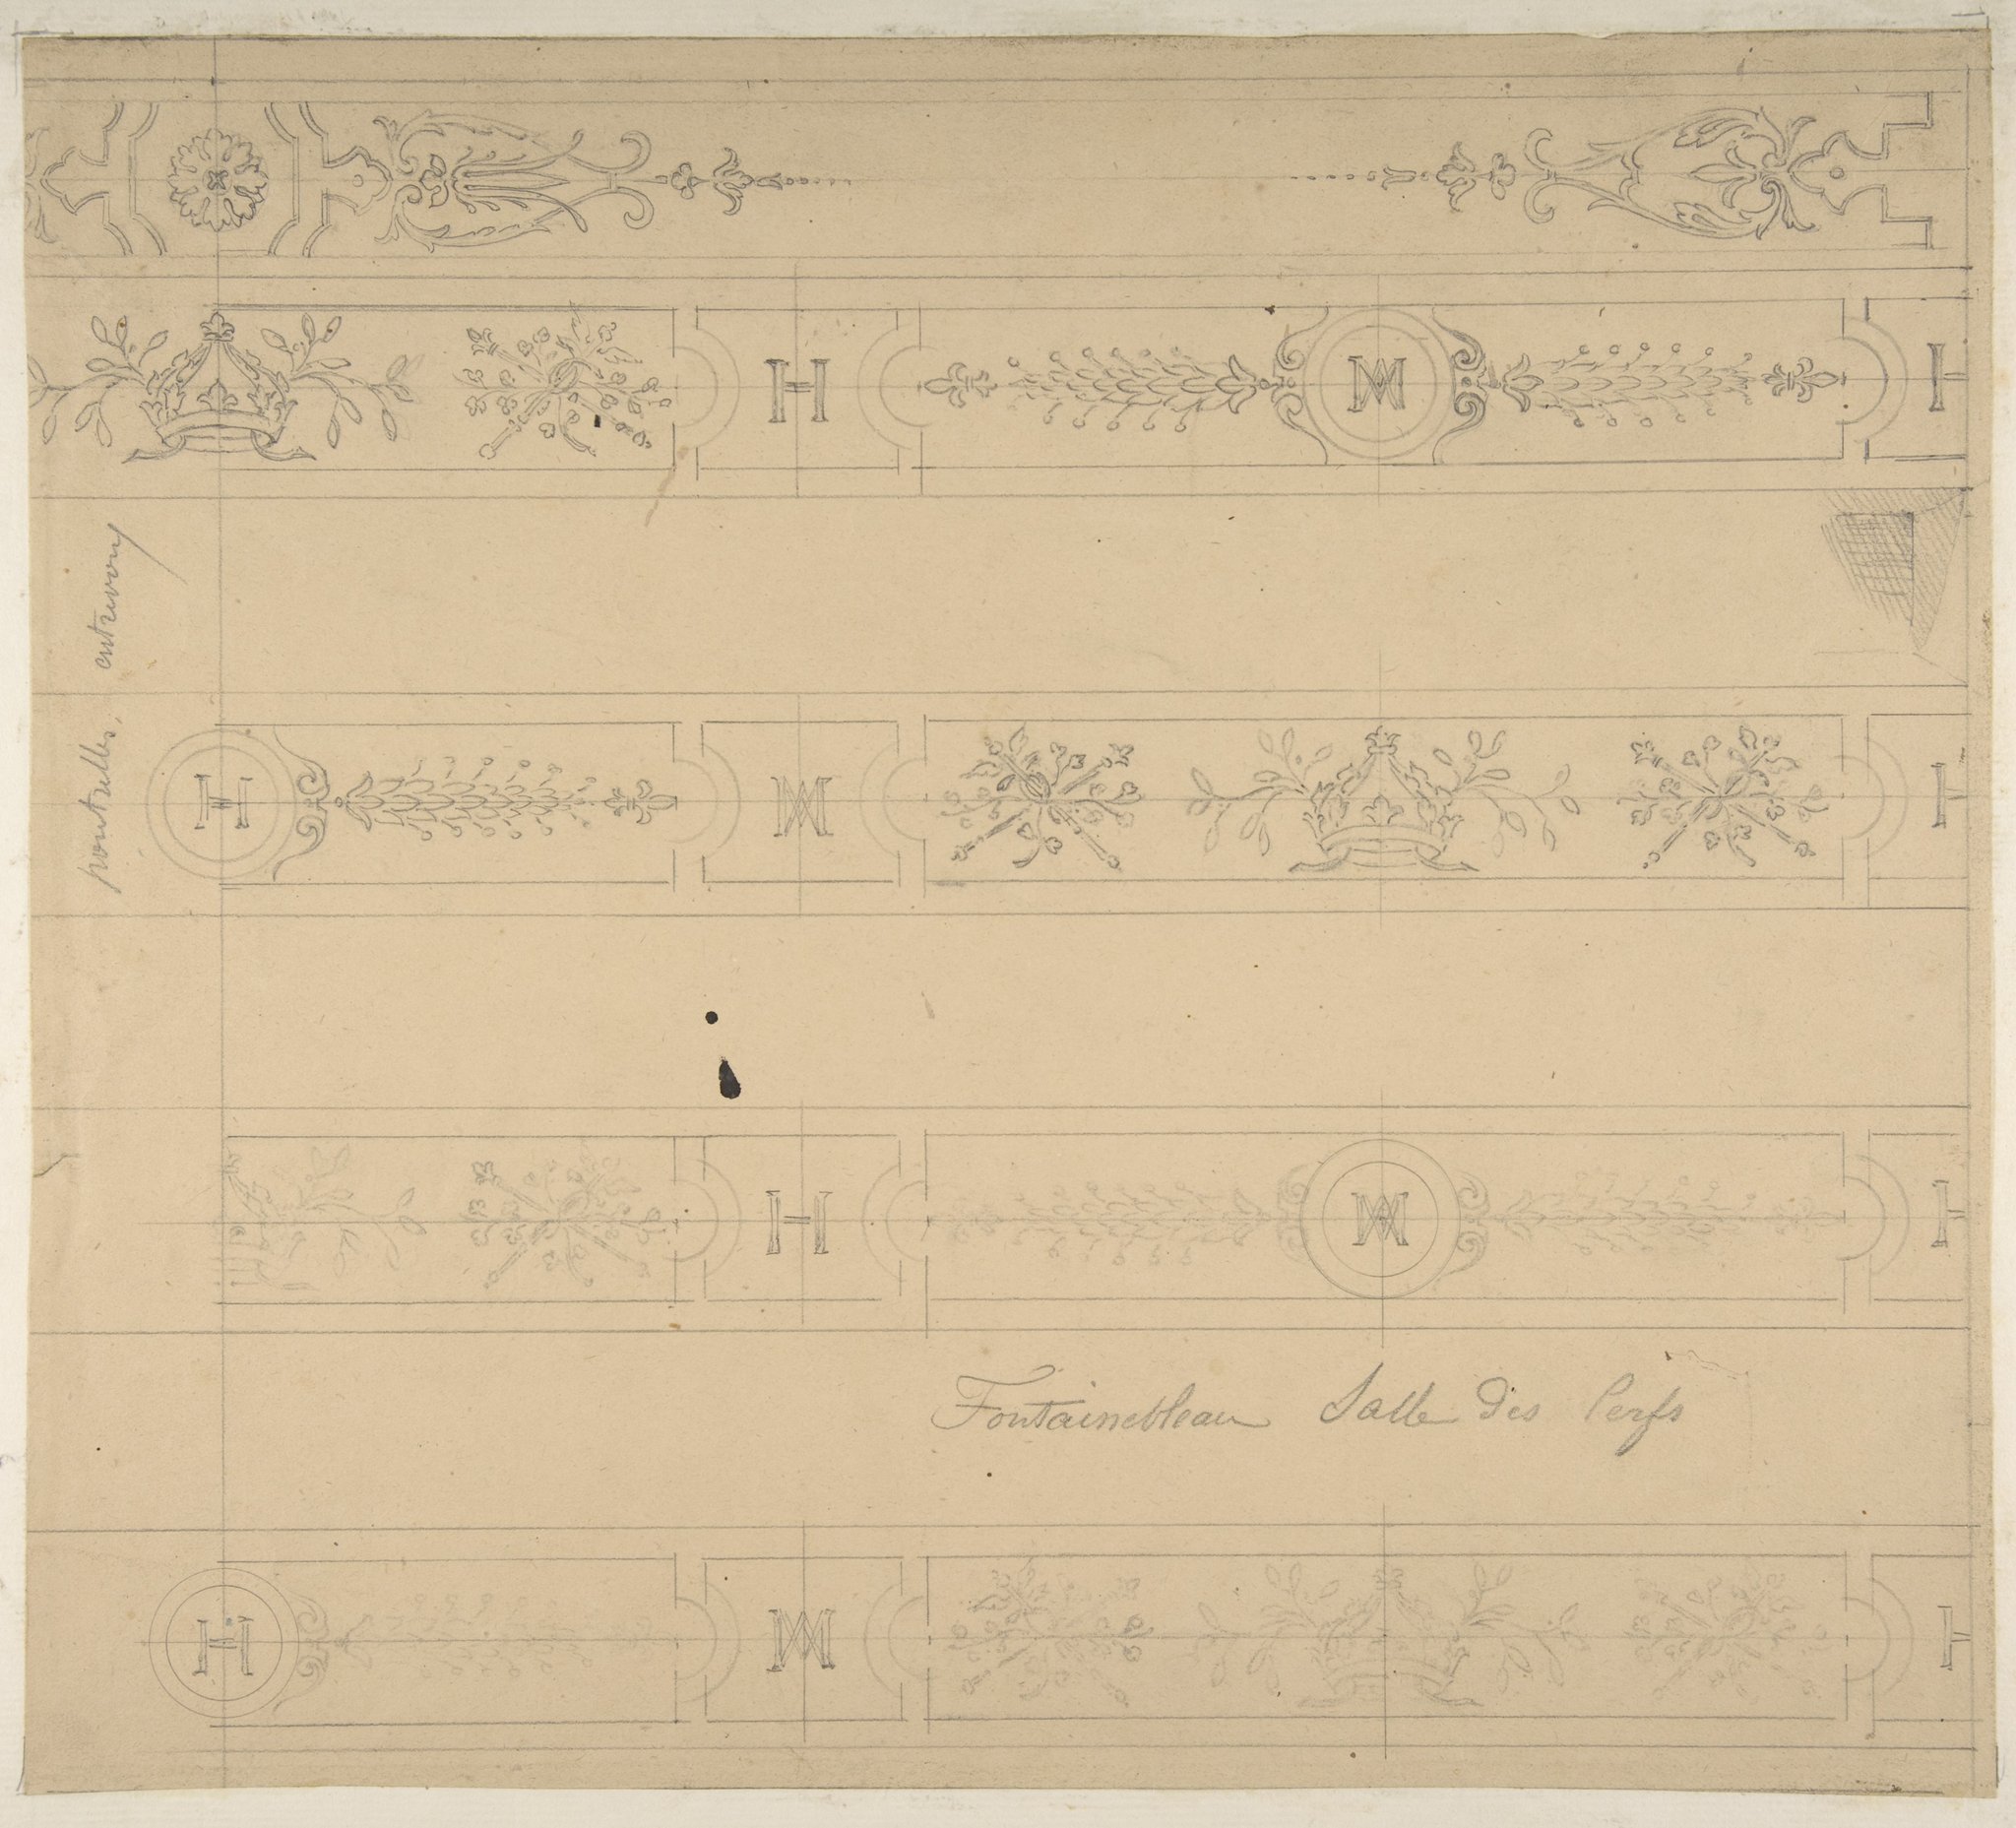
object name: drawing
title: Ceiling Design for the "Salle des Cerfs", Fontainebleau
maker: jules-edmond-charles lachaise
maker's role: artist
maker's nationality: french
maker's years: 1897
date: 1851-1900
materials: graphite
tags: flowers,leaves